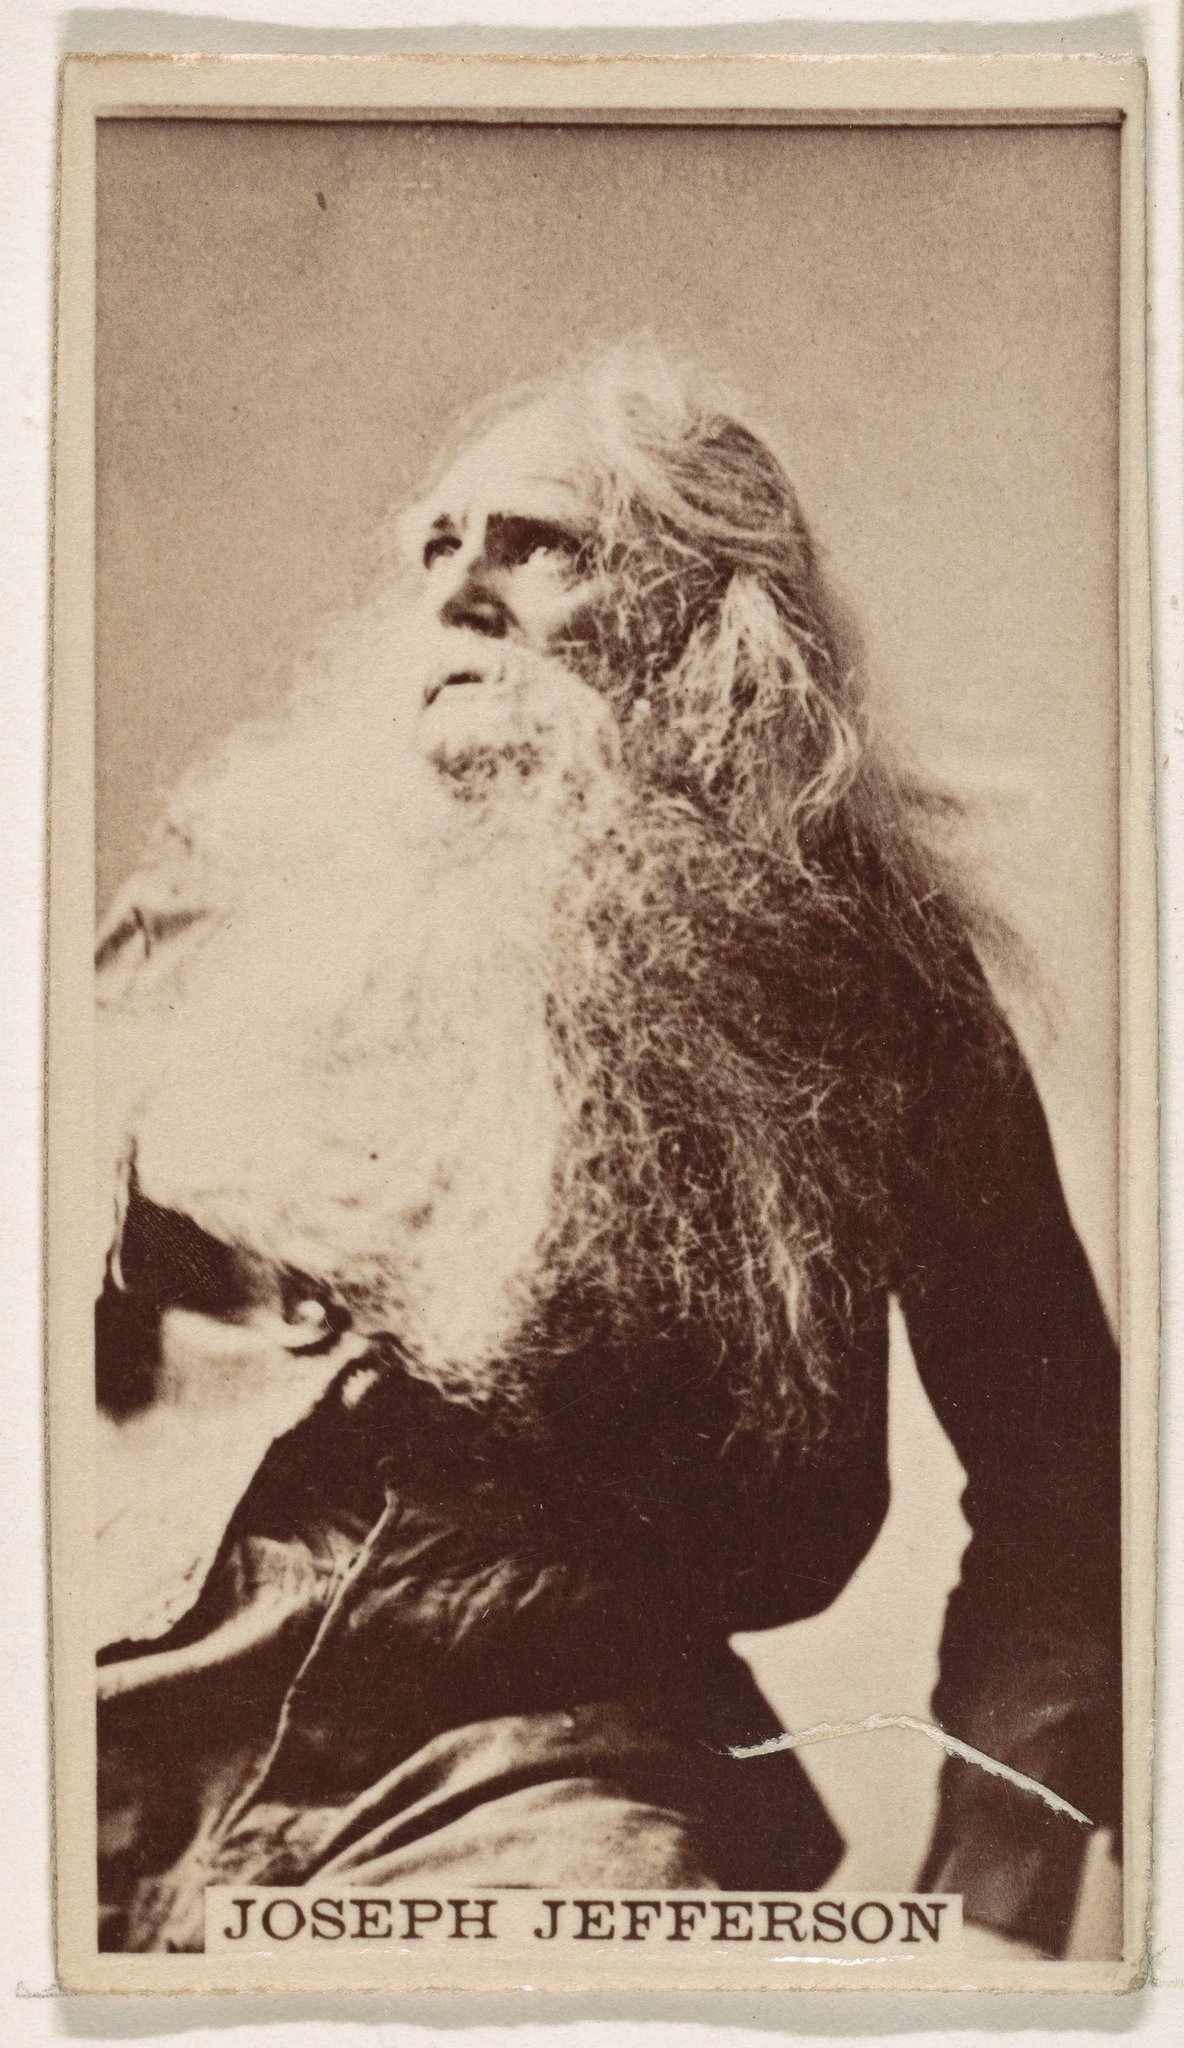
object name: photograph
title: Joseph Jefferson, from the Actresses series (N245) issued by Kinney Brothers to promote Sweet Caporal Cigarettes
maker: kinney brothers tobacco company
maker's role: publisher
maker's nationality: american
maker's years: 1869-2011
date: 1890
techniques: albumen silver print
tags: men,portraits,actors